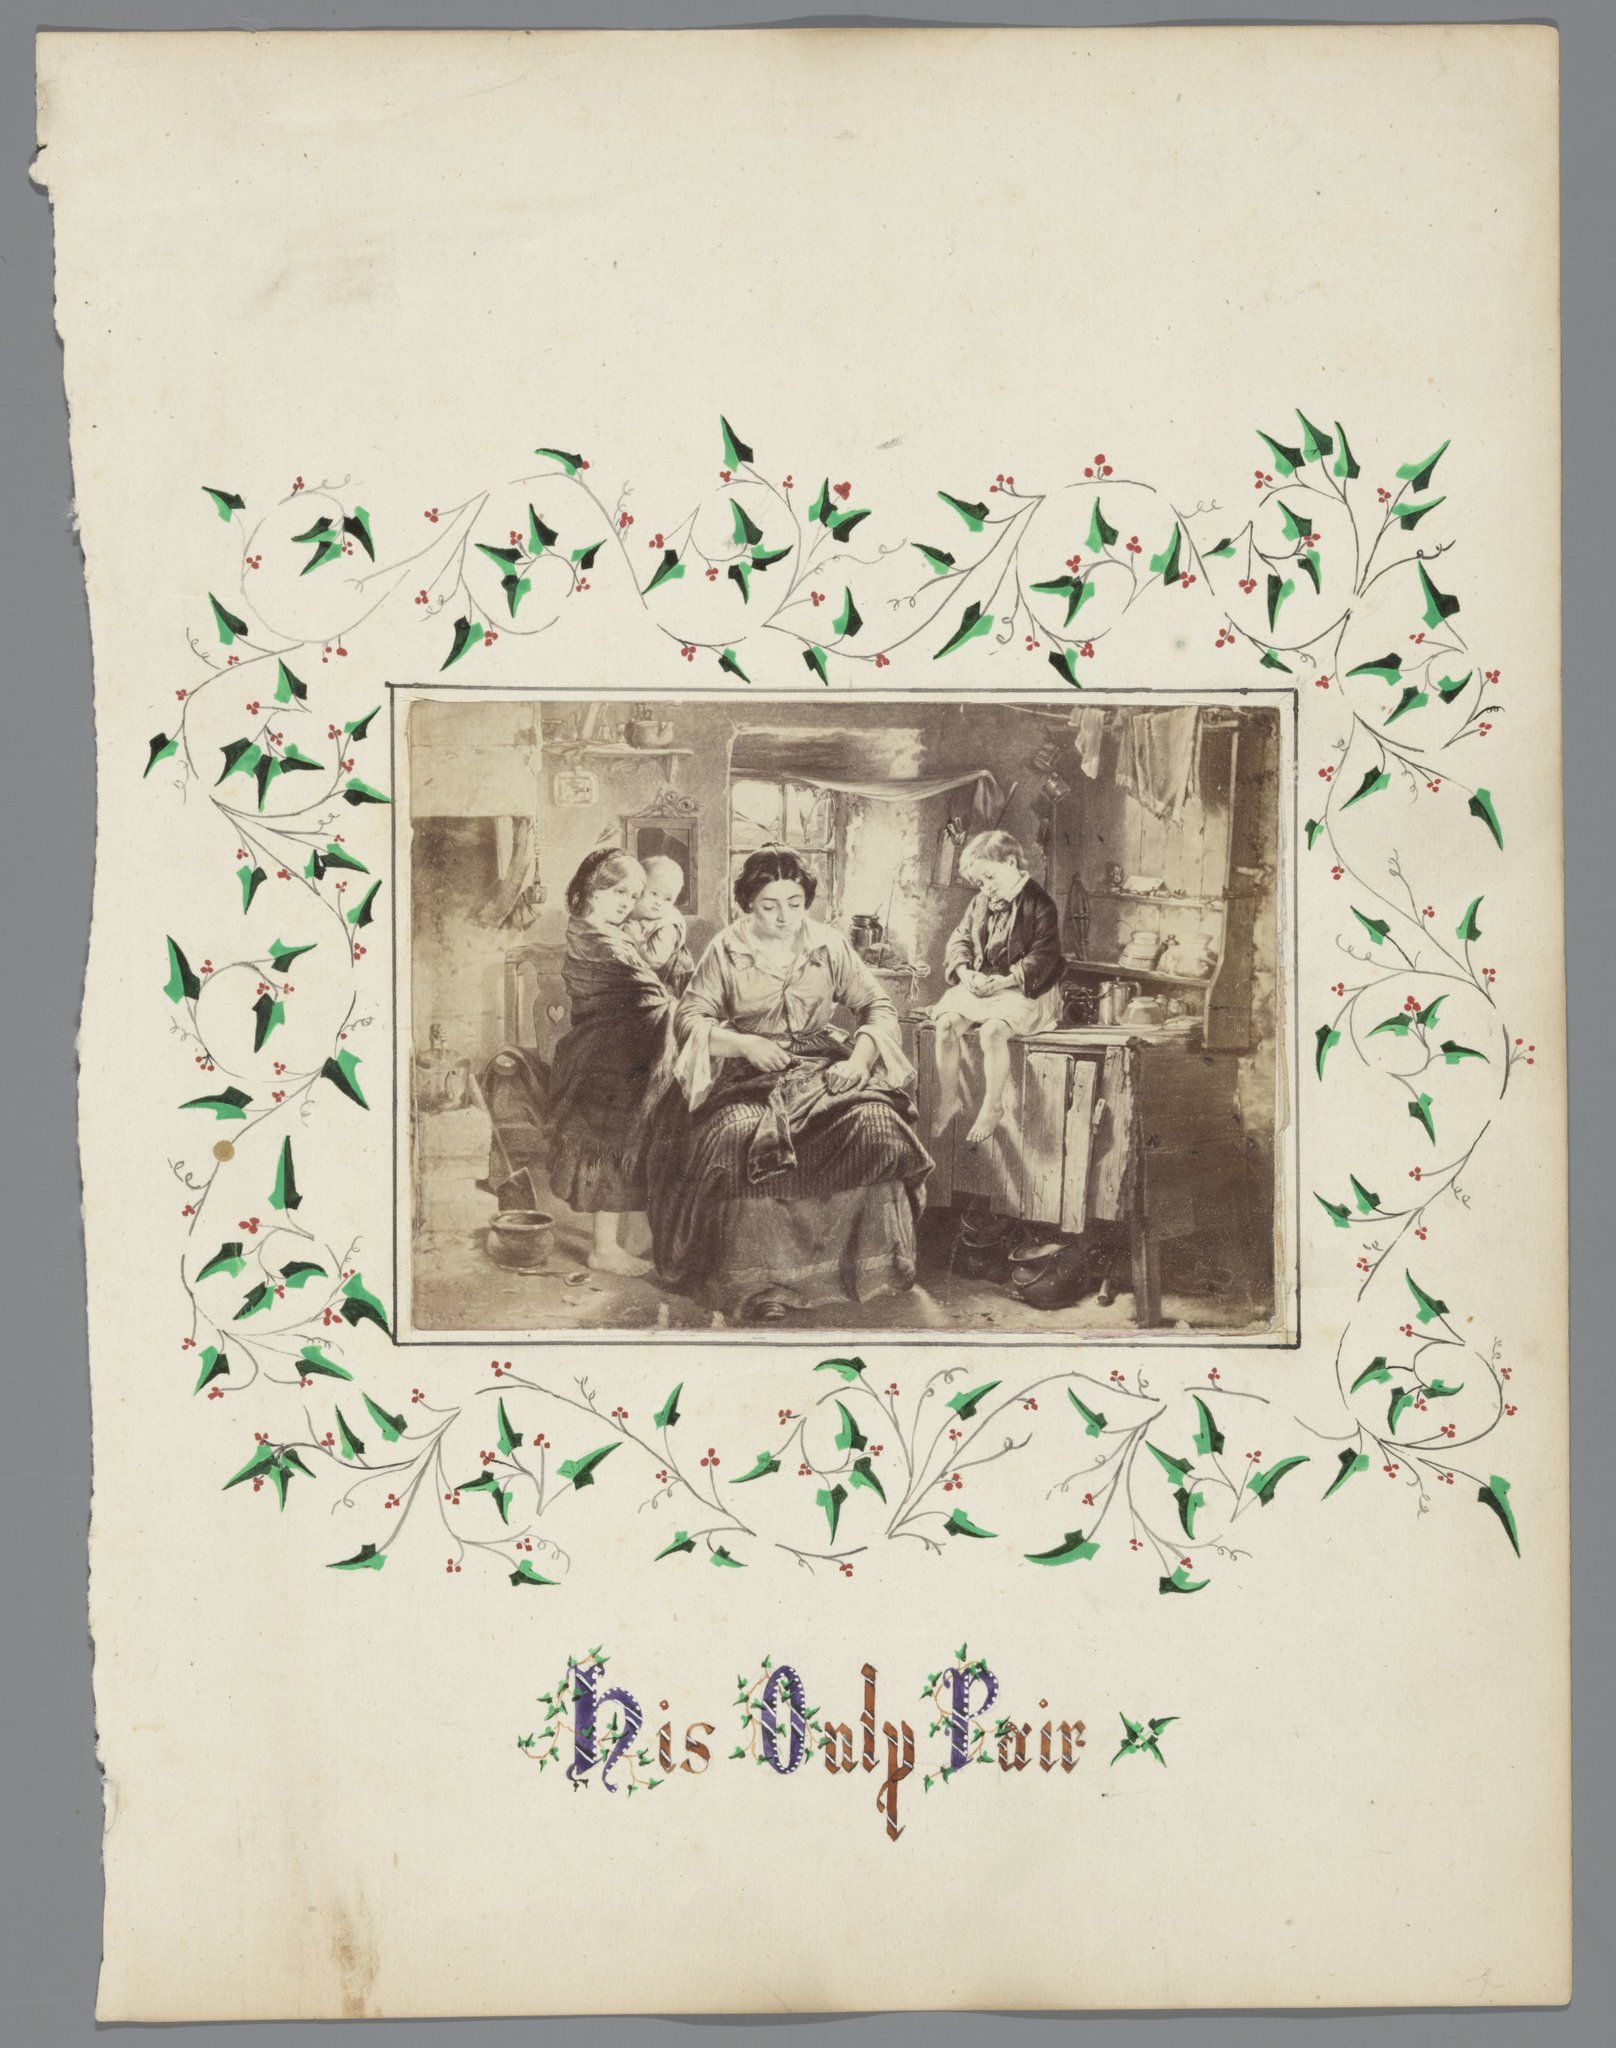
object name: album leaf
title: His only pair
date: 1870-1890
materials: paper, watercolor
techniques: albumen print, brush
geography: great britain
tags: trousers, breeches, home sewing; repair of clothes, foliage, tendrils, branches ~ ornament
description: Los albumblad met foto van het schilderij getiteld 'His only pair', voorstellende een jongen wiens broek hersteld wordt. Versierd met ranken met bessen en bladeren. Behorend bij fotoalbum met foto's omgeven door pentekeningen.